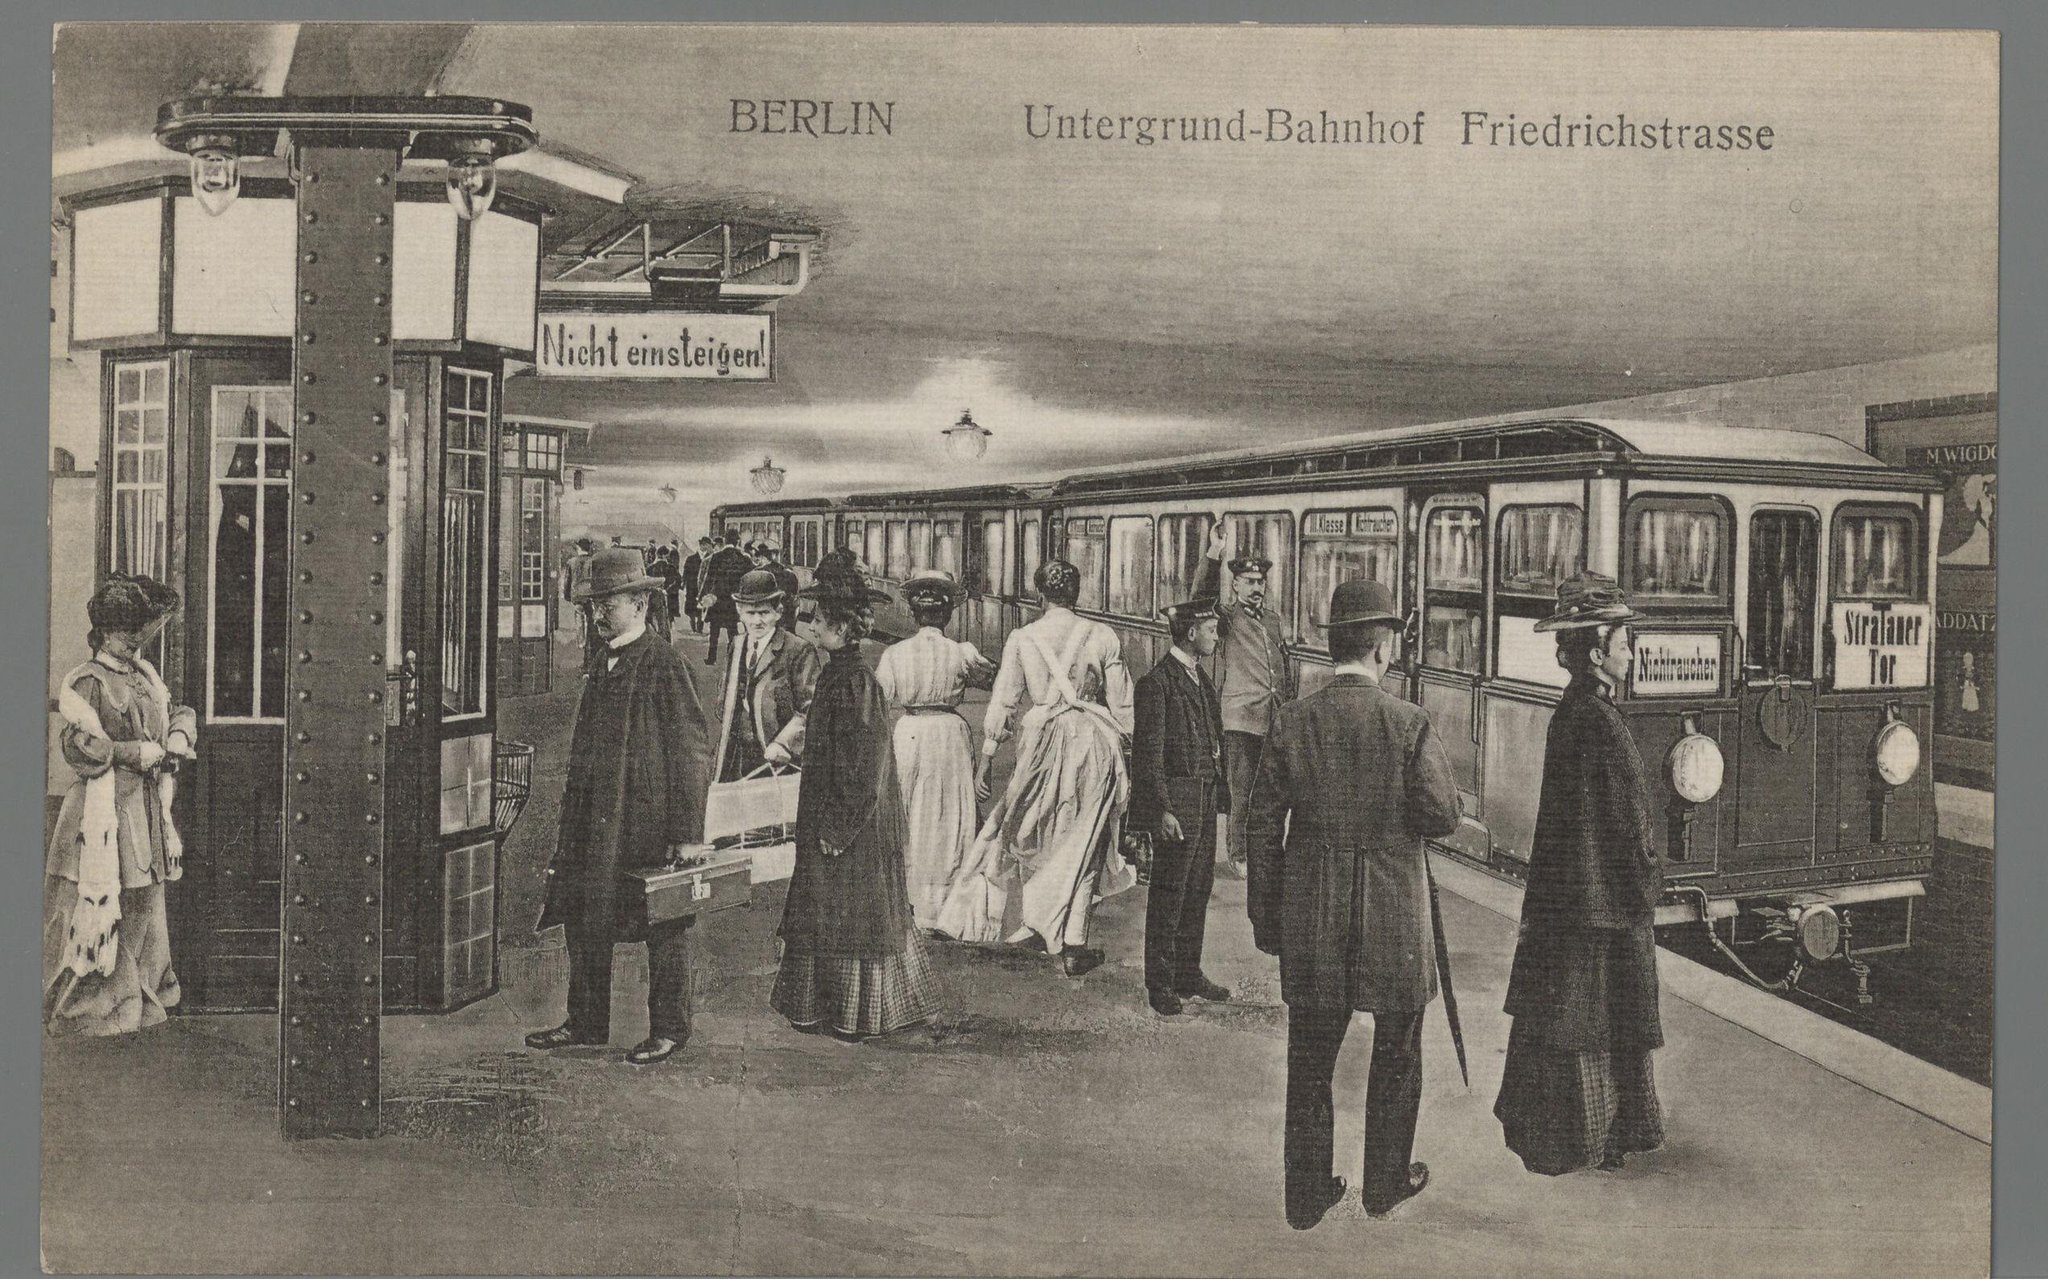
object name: photomechanical print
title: Berlin. Untergrund-Bahnhof Friedrichstrasse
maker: Anonymous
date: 1905-1930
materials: cardboard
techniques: photograph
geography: berlin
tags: underground station